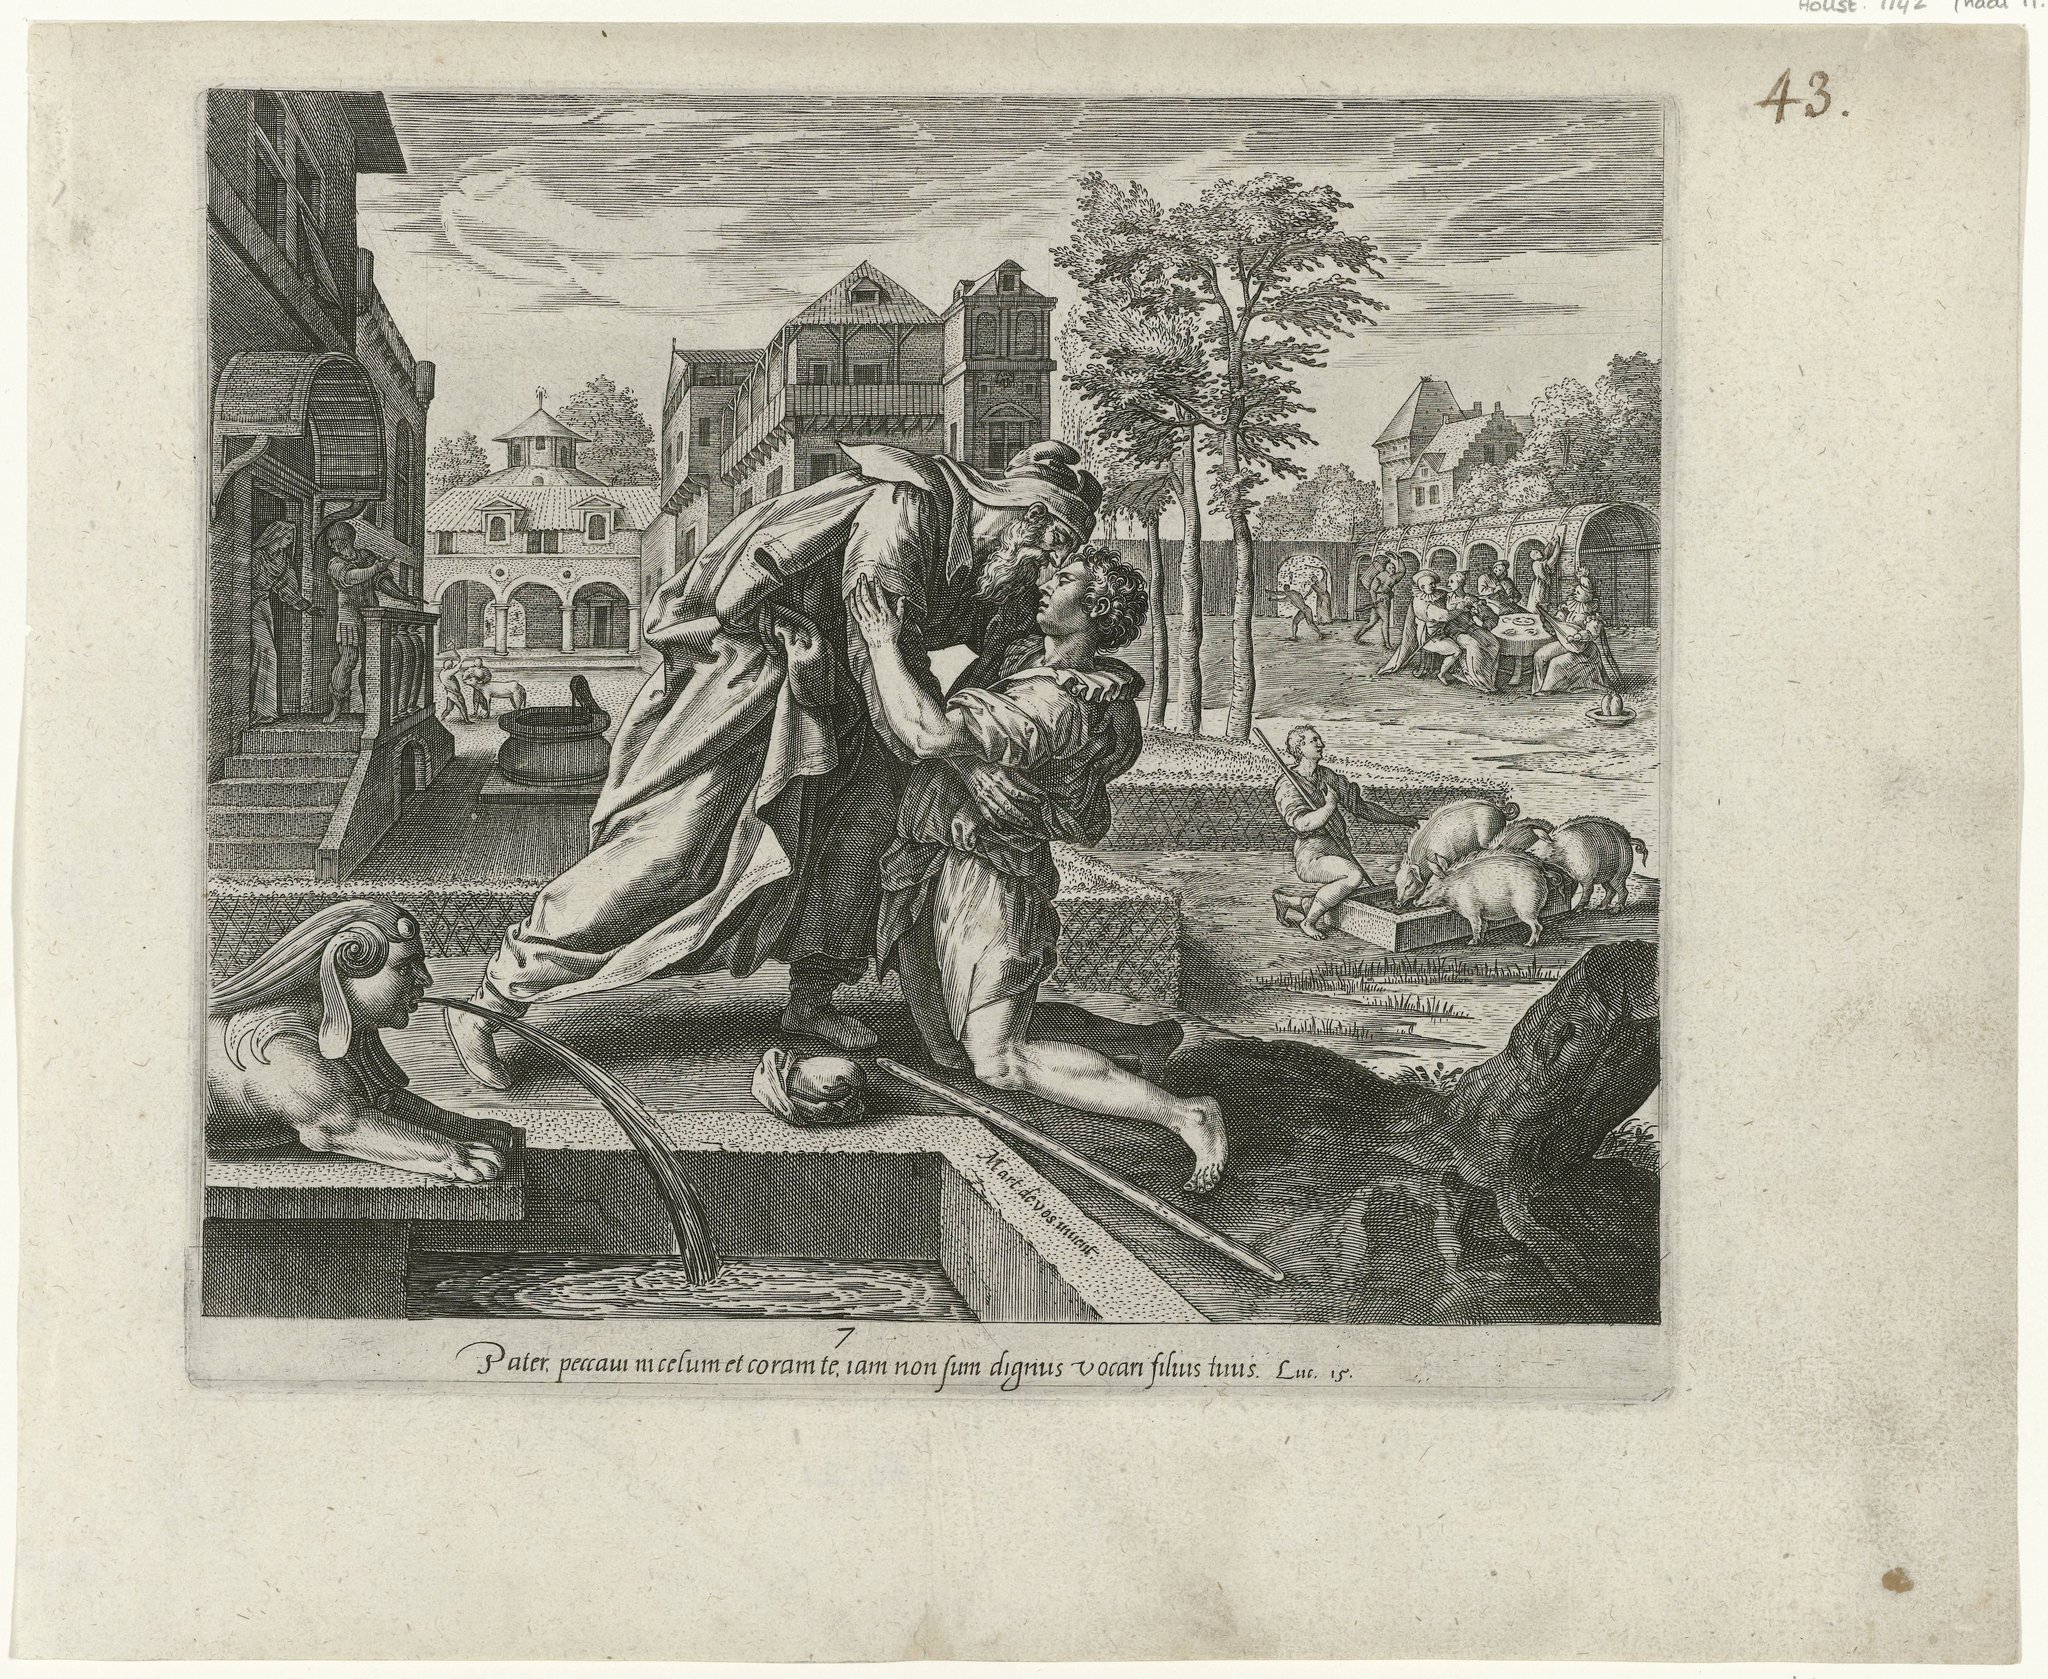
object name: print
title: Boetedoening en berouw in het Oude en Nieuwe Testament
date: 1547-1612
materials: paper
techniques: engraving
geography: antwerp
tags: the prodigal son kneels before his father who takes him in his arms, the parable of the prodigal son (luke 15:11-32)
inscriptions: collector's mark: Lugt 2760, collector's mark: Lugt 2228, number: ‘43’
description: Het verhaal van de verloren zoon. Centraal wordt de verloren zoon, teruggekeerd van zijn reis, door zijn oude vader vergeven. De prent heeft een Latijns onderschrift en is deel van een serie over boetedoening en berouw in het Oude en Nieuwe Testament.